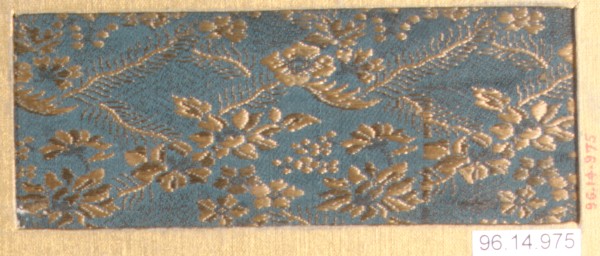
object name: piece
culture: japanese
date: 1701-1900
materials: silk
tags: flowers